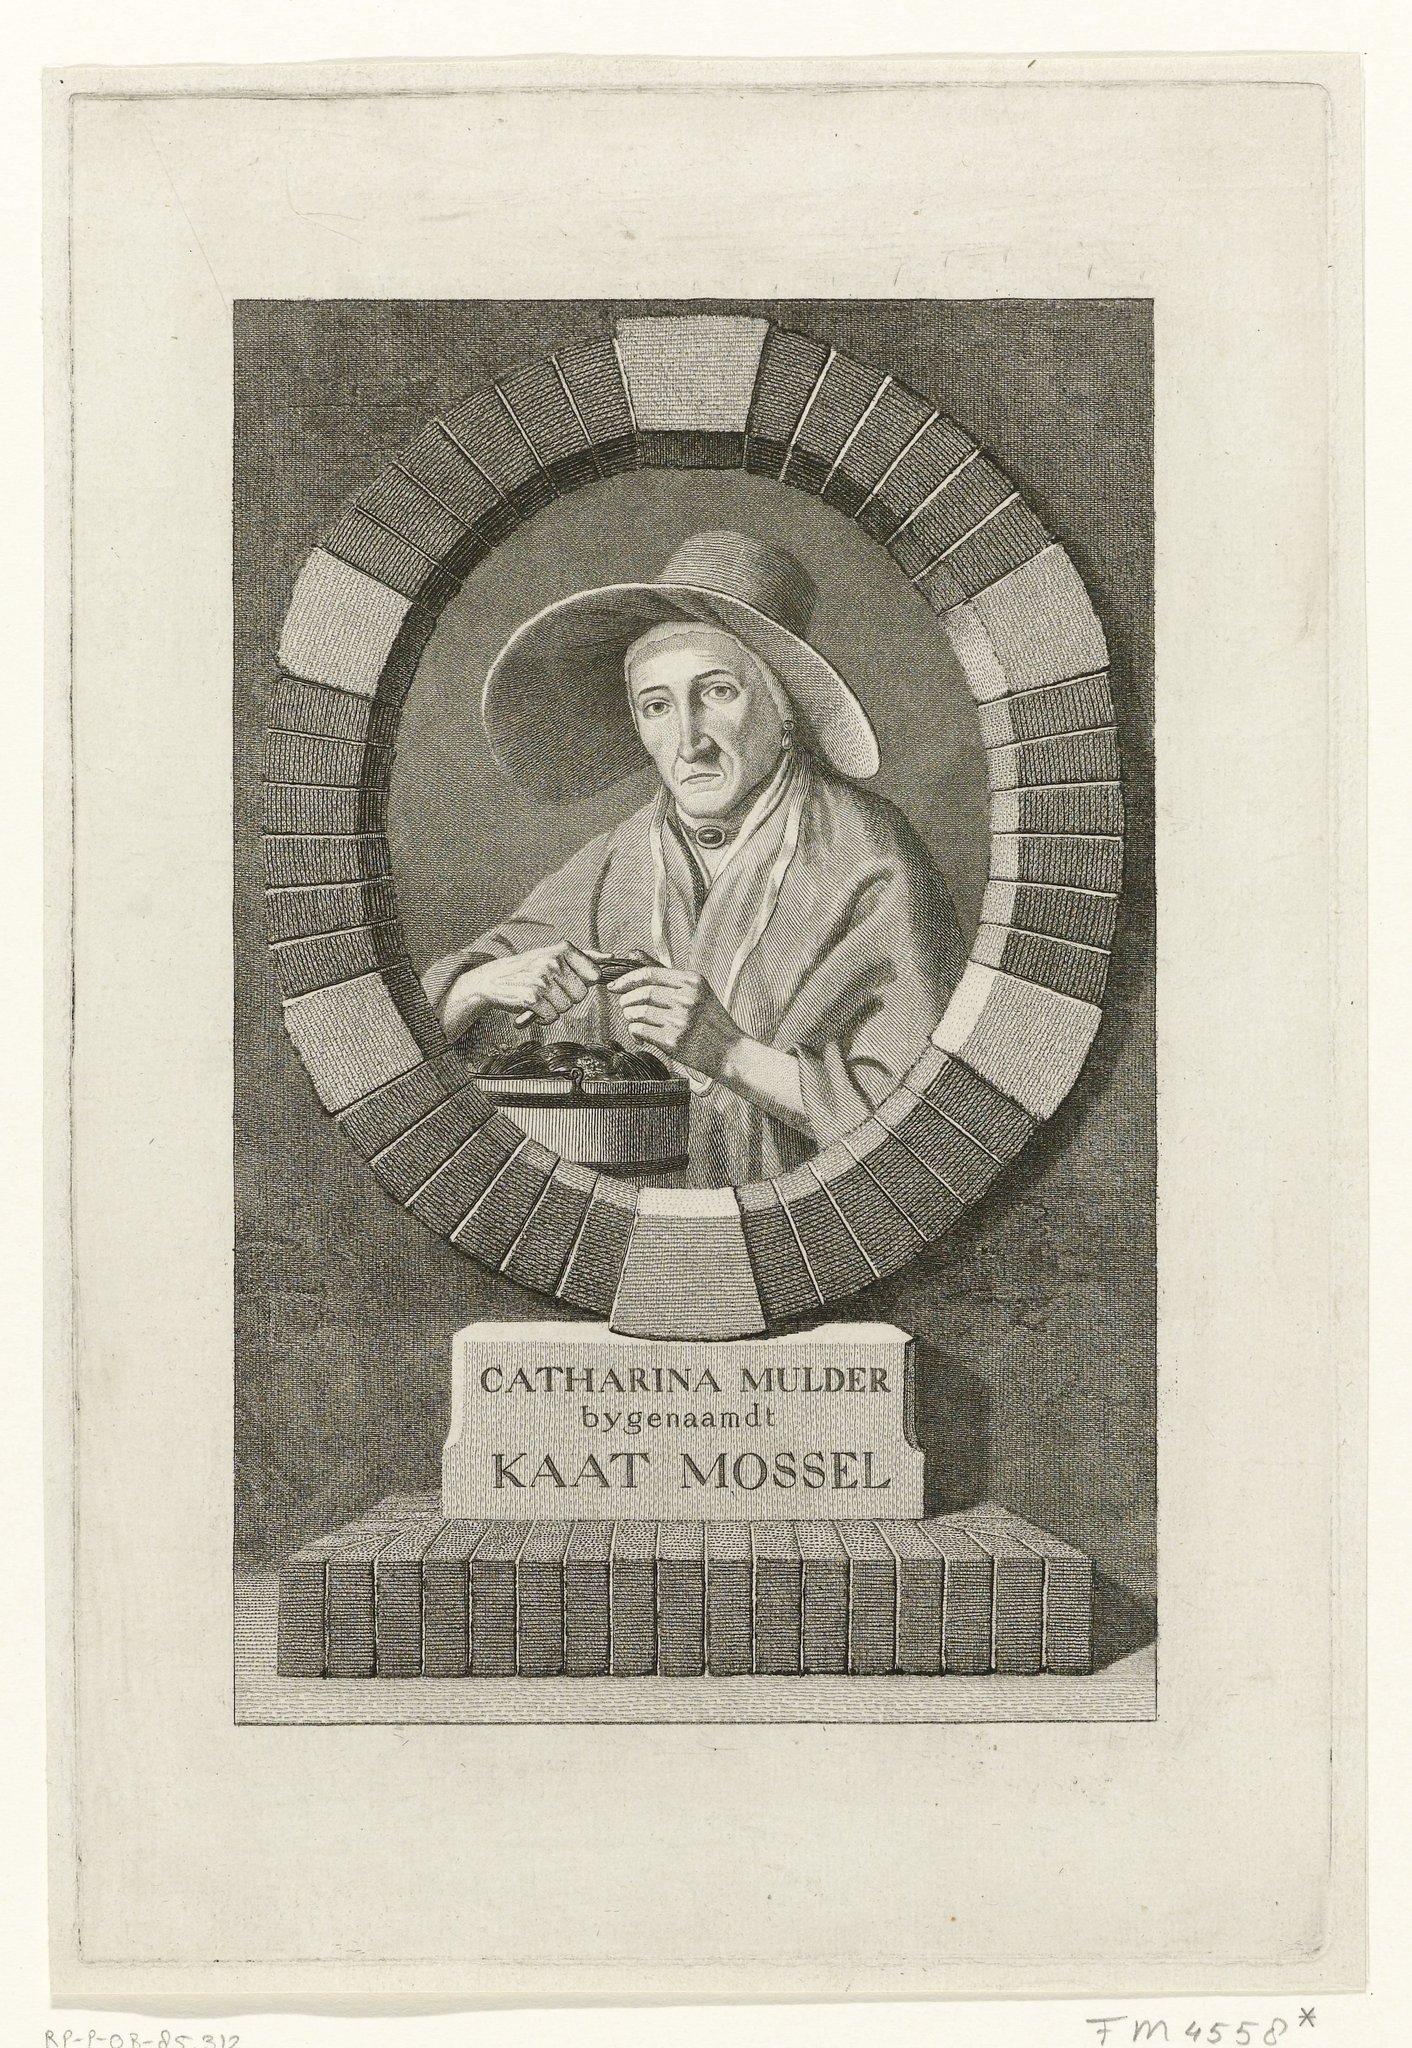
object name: print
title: Catharina Mulder bygenaamdt Kaat Mossel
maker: Anonymous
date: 1784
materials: paper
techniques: engraving, etching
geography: northern netherlands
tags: kaat mossel, rotterdam, patriots (1780-1795)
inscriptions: collector's mark: Lugt 2228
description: Portret van Kaat Mossel (Catharina Mulder), 1784. Ovale stenen omlijsting met het portret van de vrouw die mossels aan het schoonmaken is.